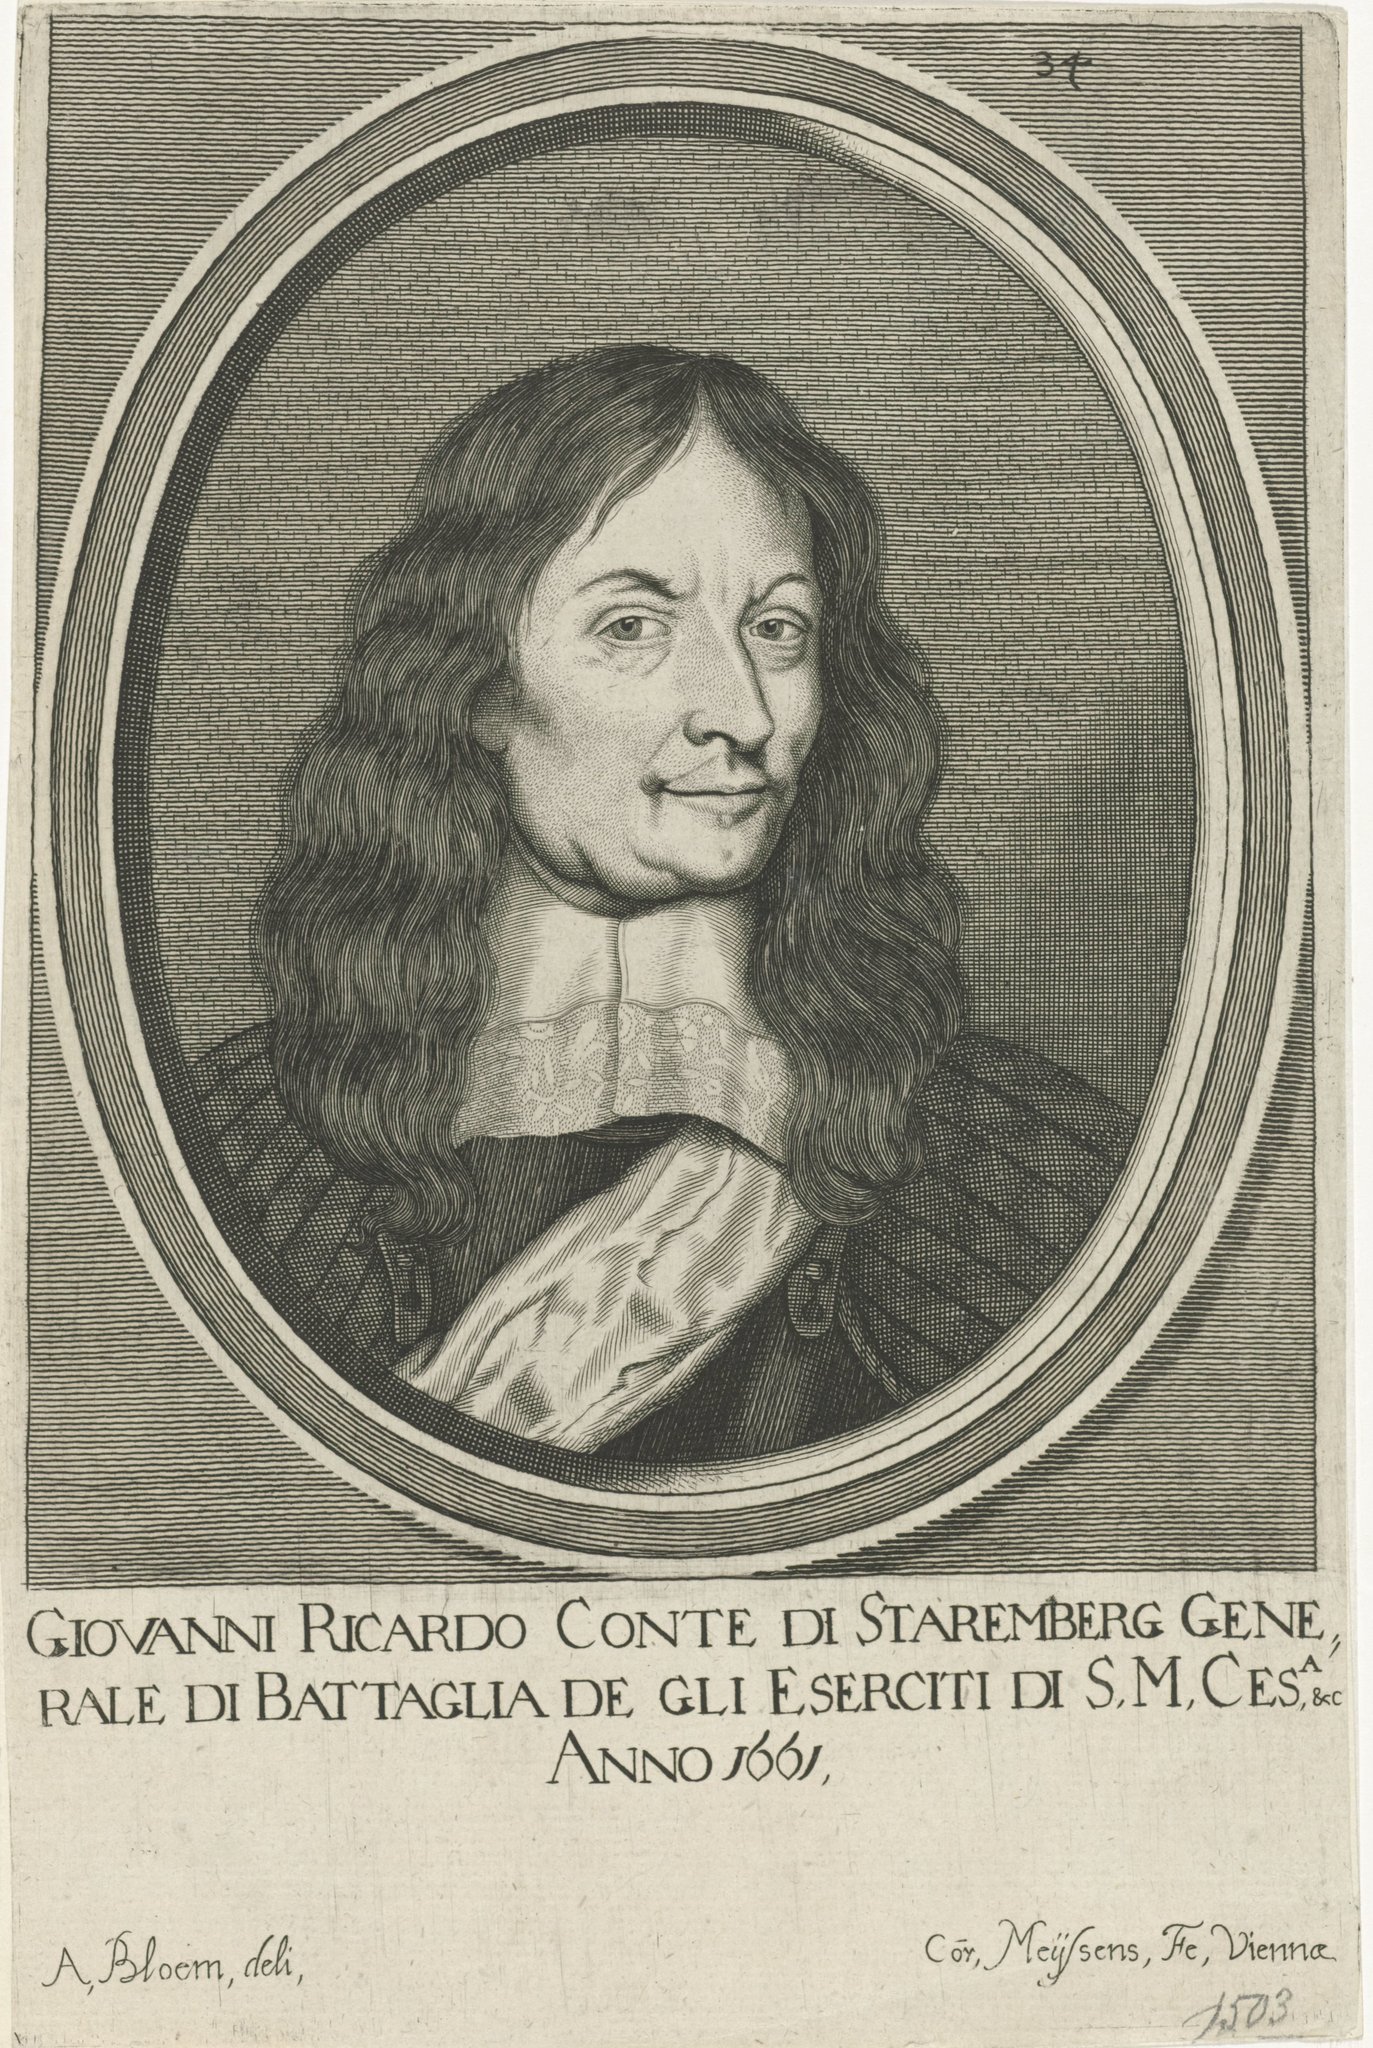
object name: print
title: Portret van Giovanni Ricardo Starhemberg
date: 1661-1699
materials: paper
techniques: engraving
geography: vienna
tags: hongarije, militair, luitenant, veldmaarschalk, kamerheer, johann reichard starhemberg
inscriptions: collector's mark: Lugt 2228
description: Prent waarschijnlijk uit: Gualdo Priorato, Galeazzo. Historia di Leopoldo Cesare (...). Wenen: Giovanni Battista Hacque, 1630, dl. 2. Het uitgavejaar 1630 is waarschijnlijk of later ingevoegd of verkeerd vermeld, aangezien het jaartal op de prent 1661 is. De uitgave zou dus van later dato moeten dateren.